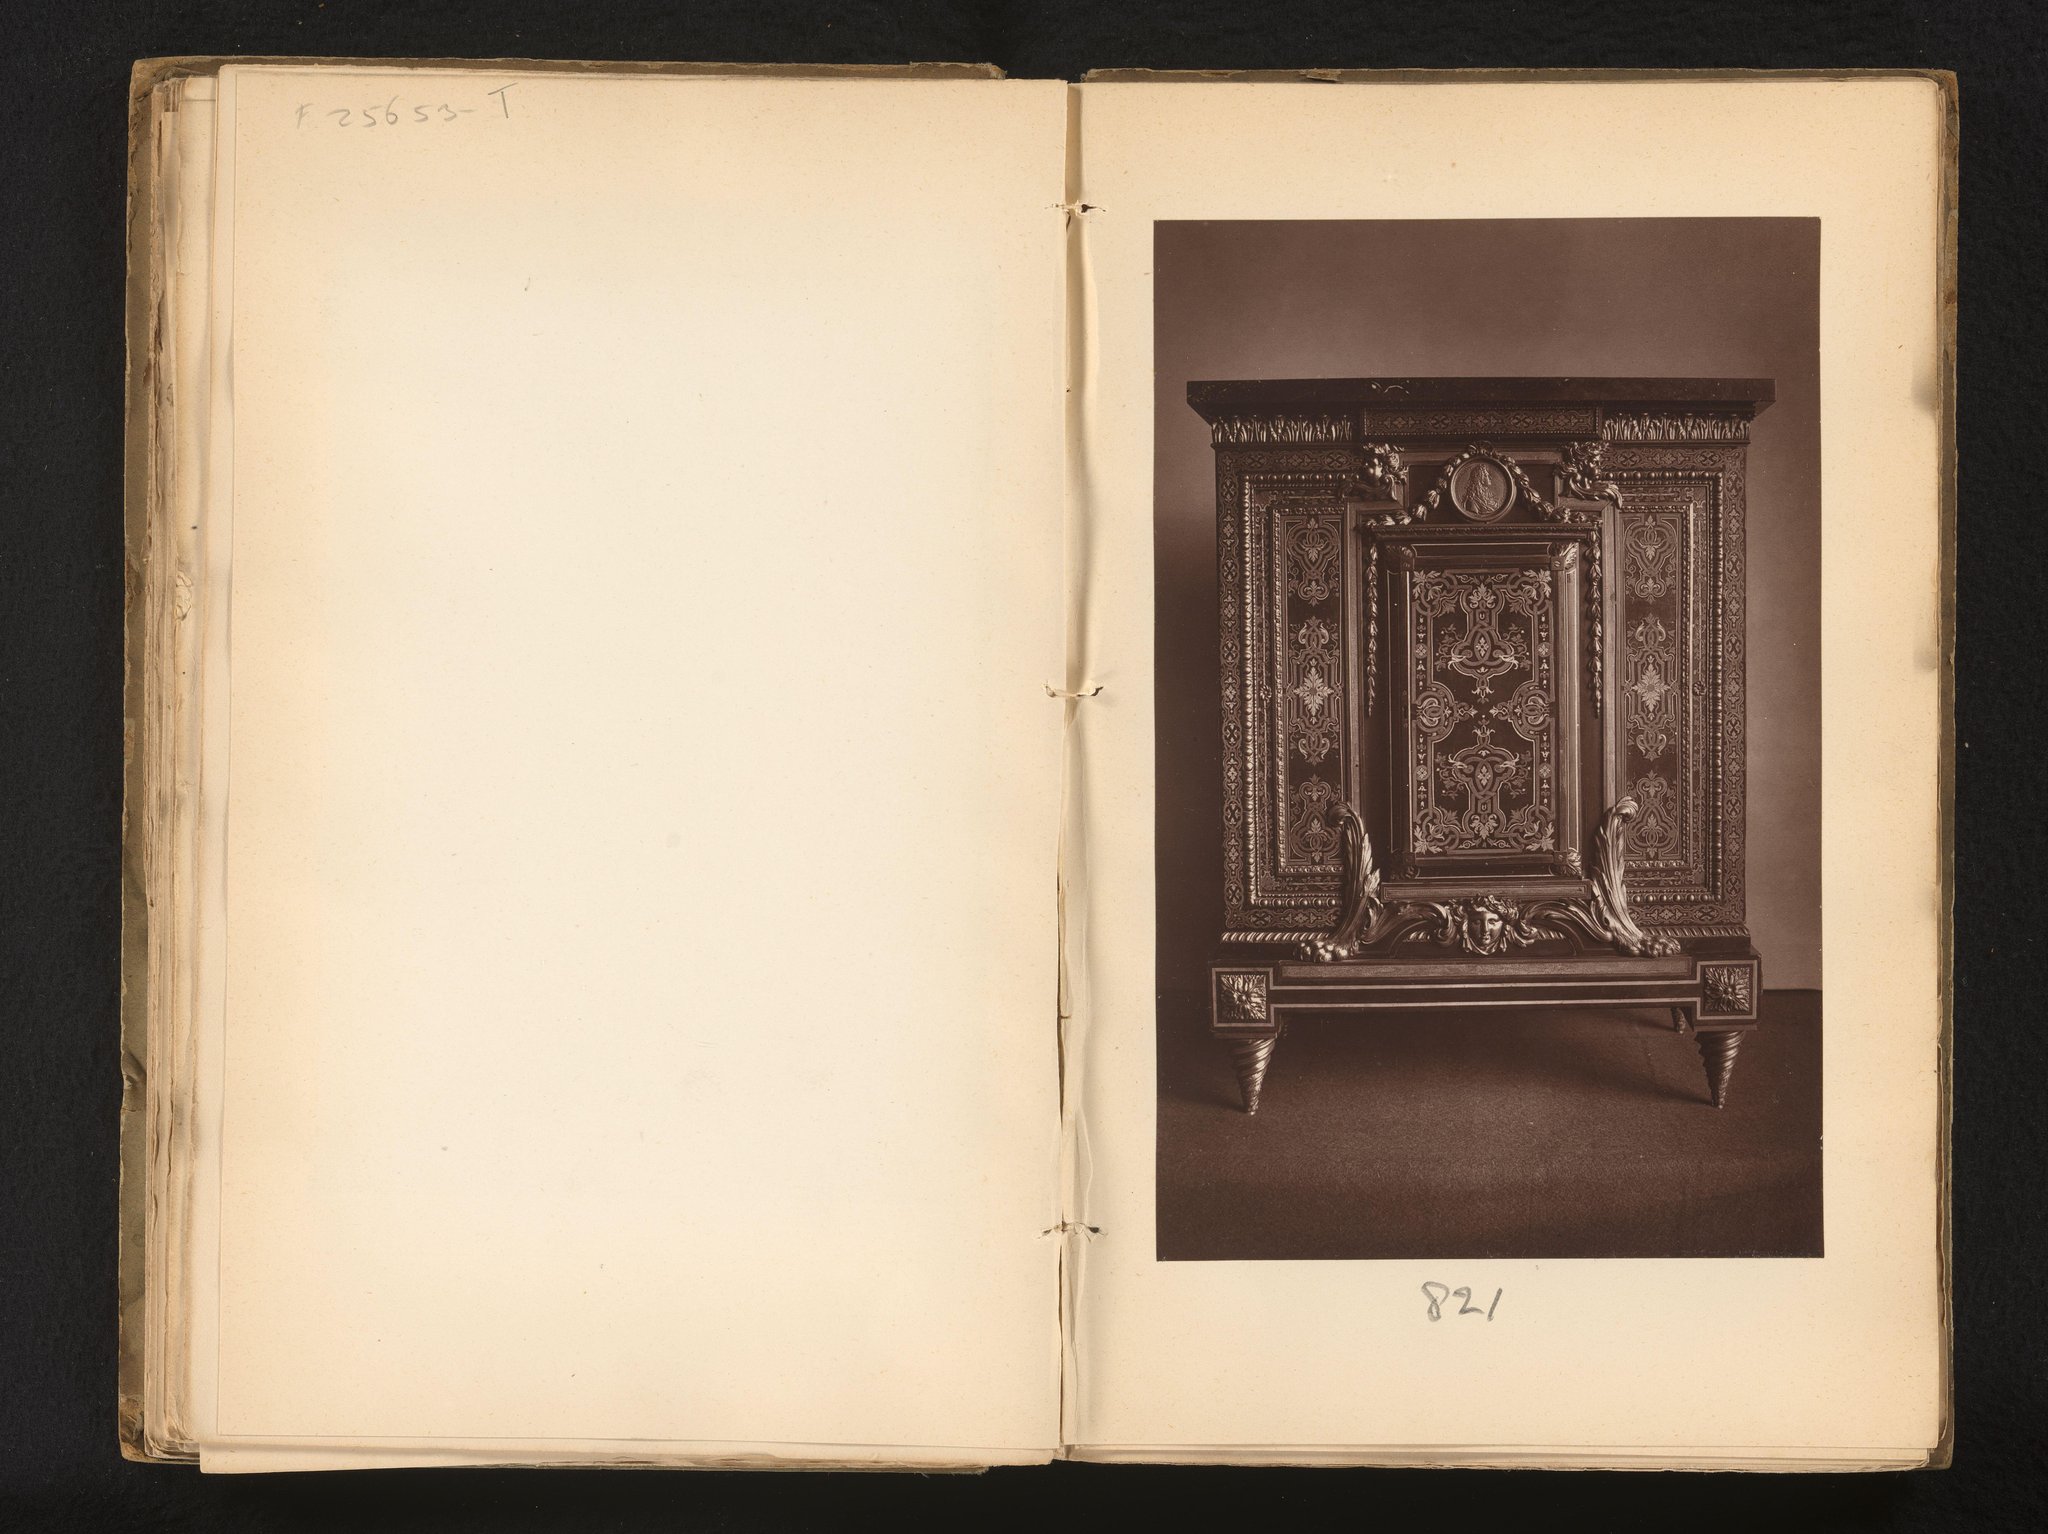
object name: photomechanical print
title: Gedecoreerd kabinet in de stijl van Lodewijk XIV, uit de collectie van Christopher Beckett Denison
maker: Anonymous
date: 1880-1885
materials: paper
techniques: woodburytype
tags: ornamental cupboard (+ wood and other phytogenic material)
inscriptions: number: ‘821’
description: Prent op derde ongenummerde pagina na pagina 82.